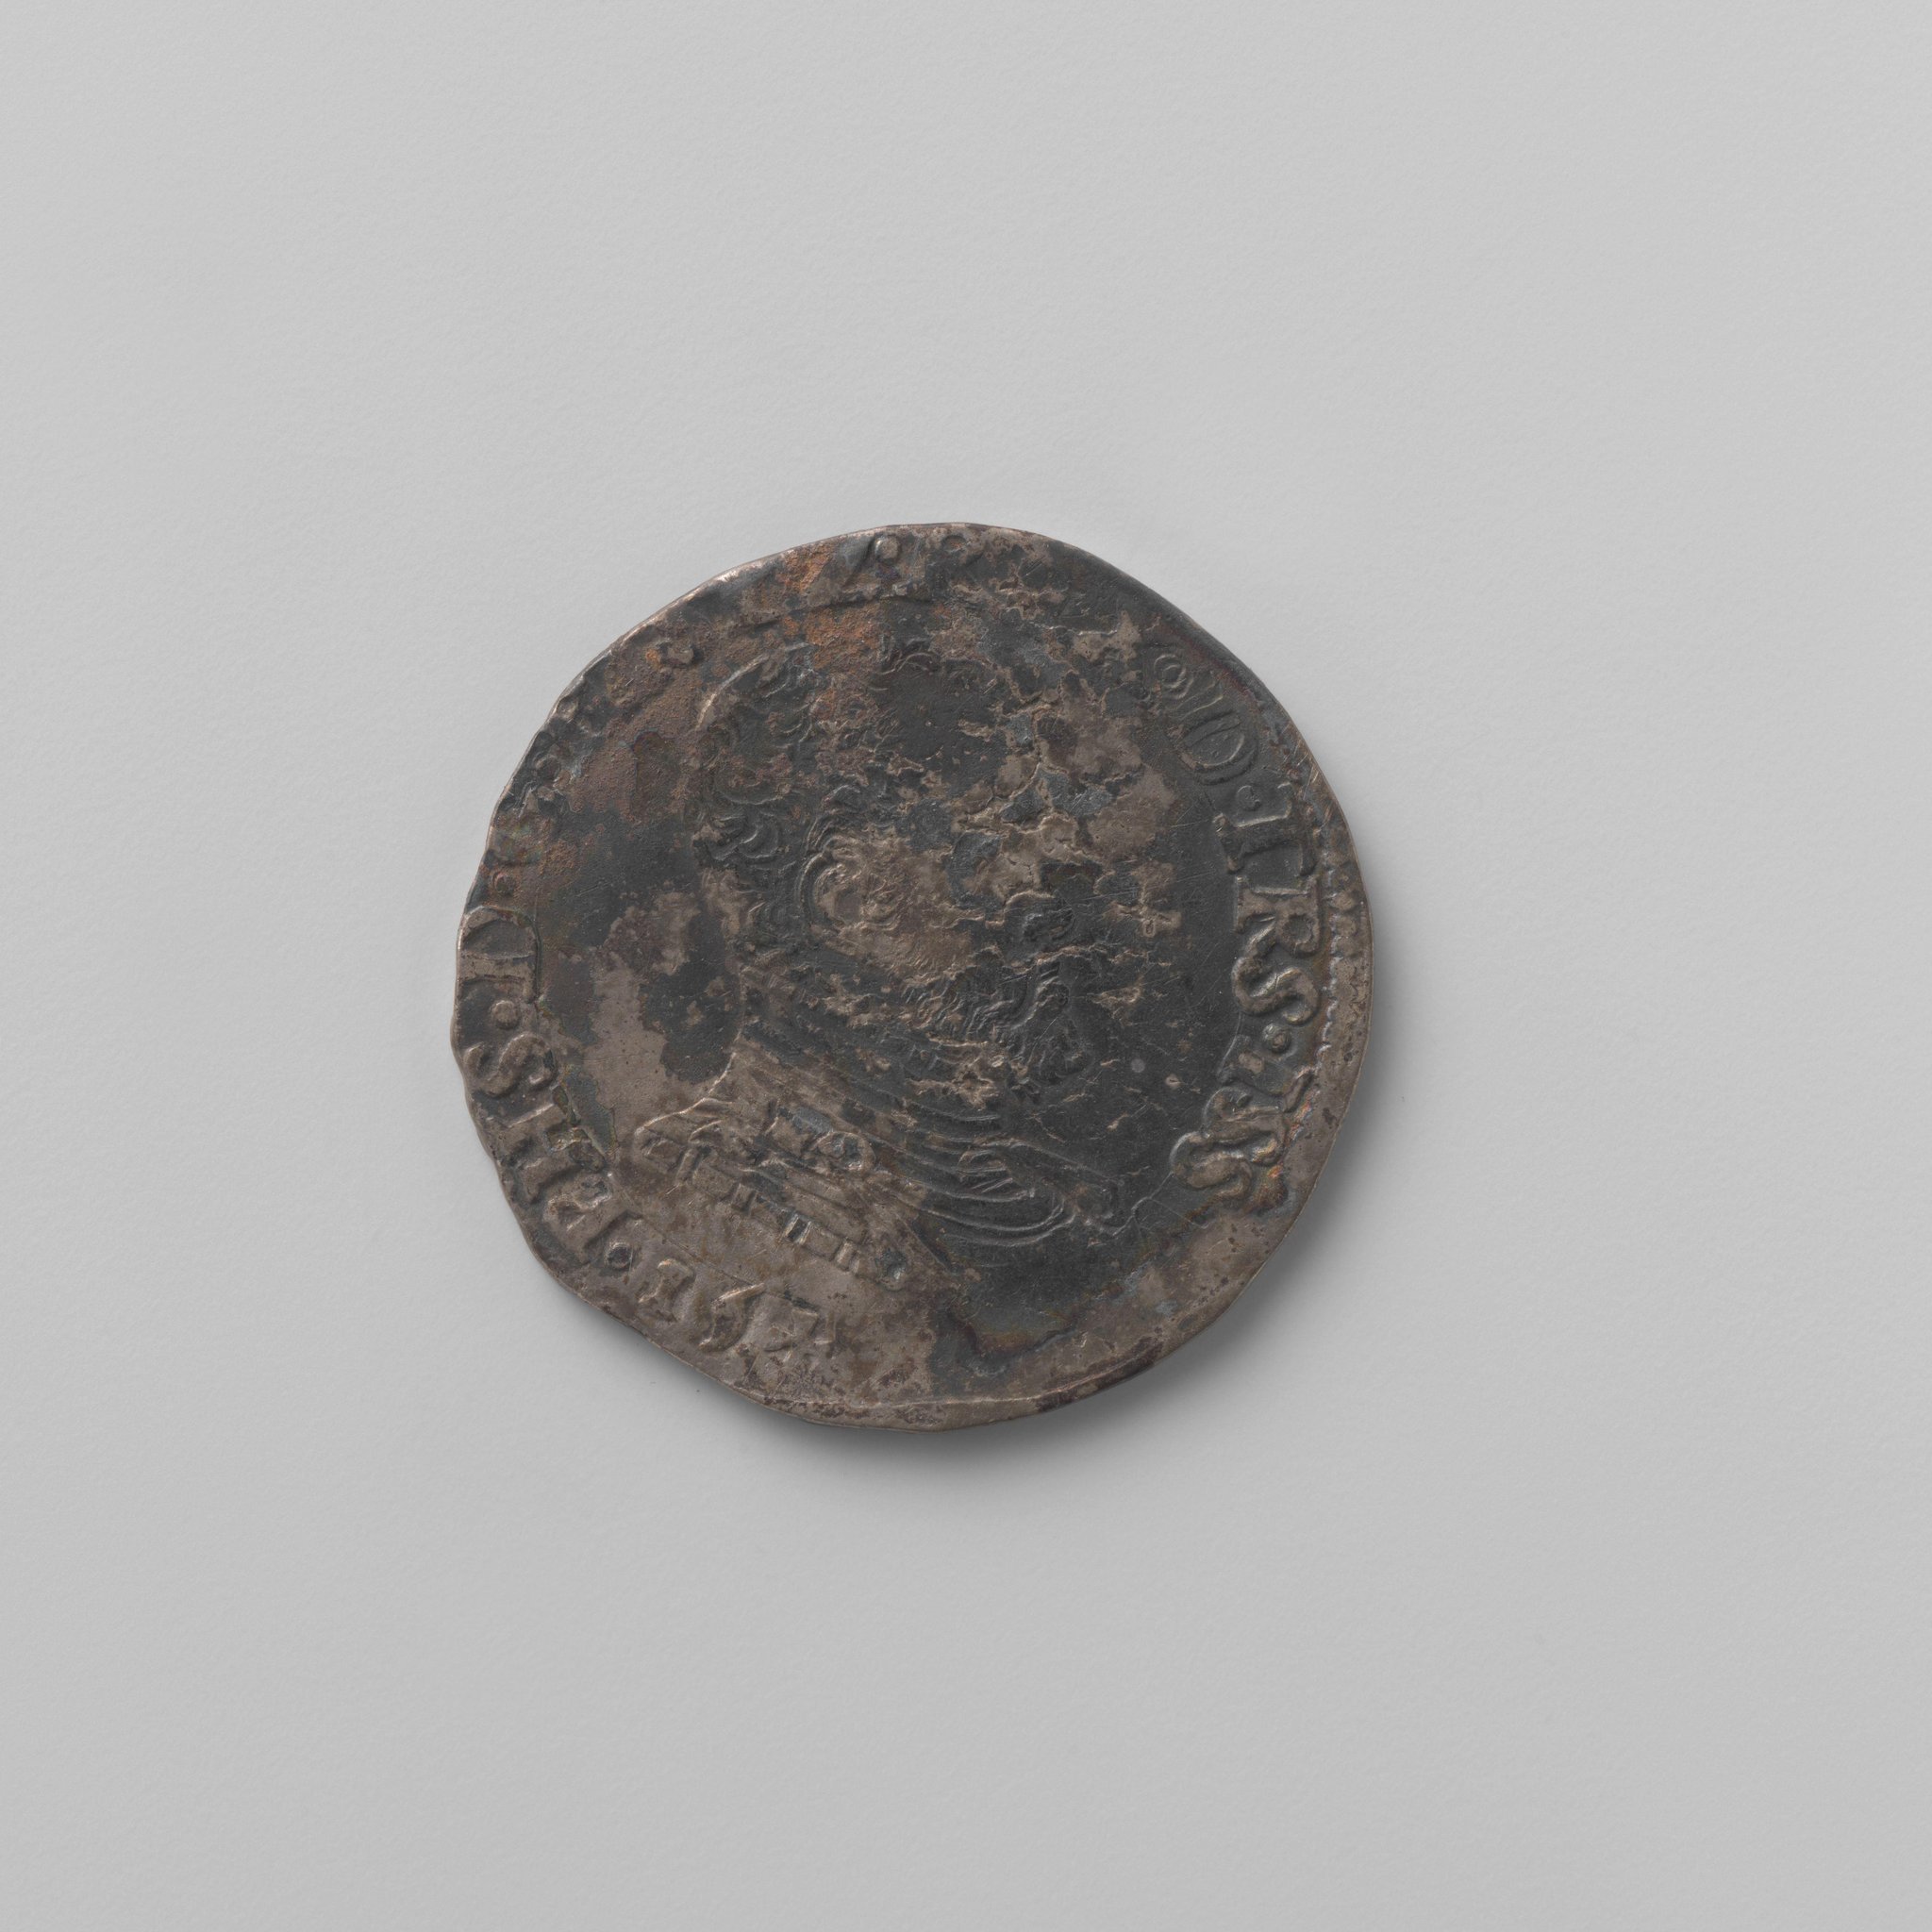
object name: coin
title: Overijssel, Philips II, 1/5 philipsdaalder, 1567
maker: philip ii of spain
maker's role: koning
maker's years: 1527-1598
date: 1567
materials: silver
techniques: striking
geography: hasselt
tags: philip ii of spain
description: Zilveren munt. Voorzijde: tussen twee vuurstenen gekroond Spaans-Bourgondisch wapenschild op stokkenkruis. Keerzijde: portret Philips II naar rechts, daaronder jaartal.